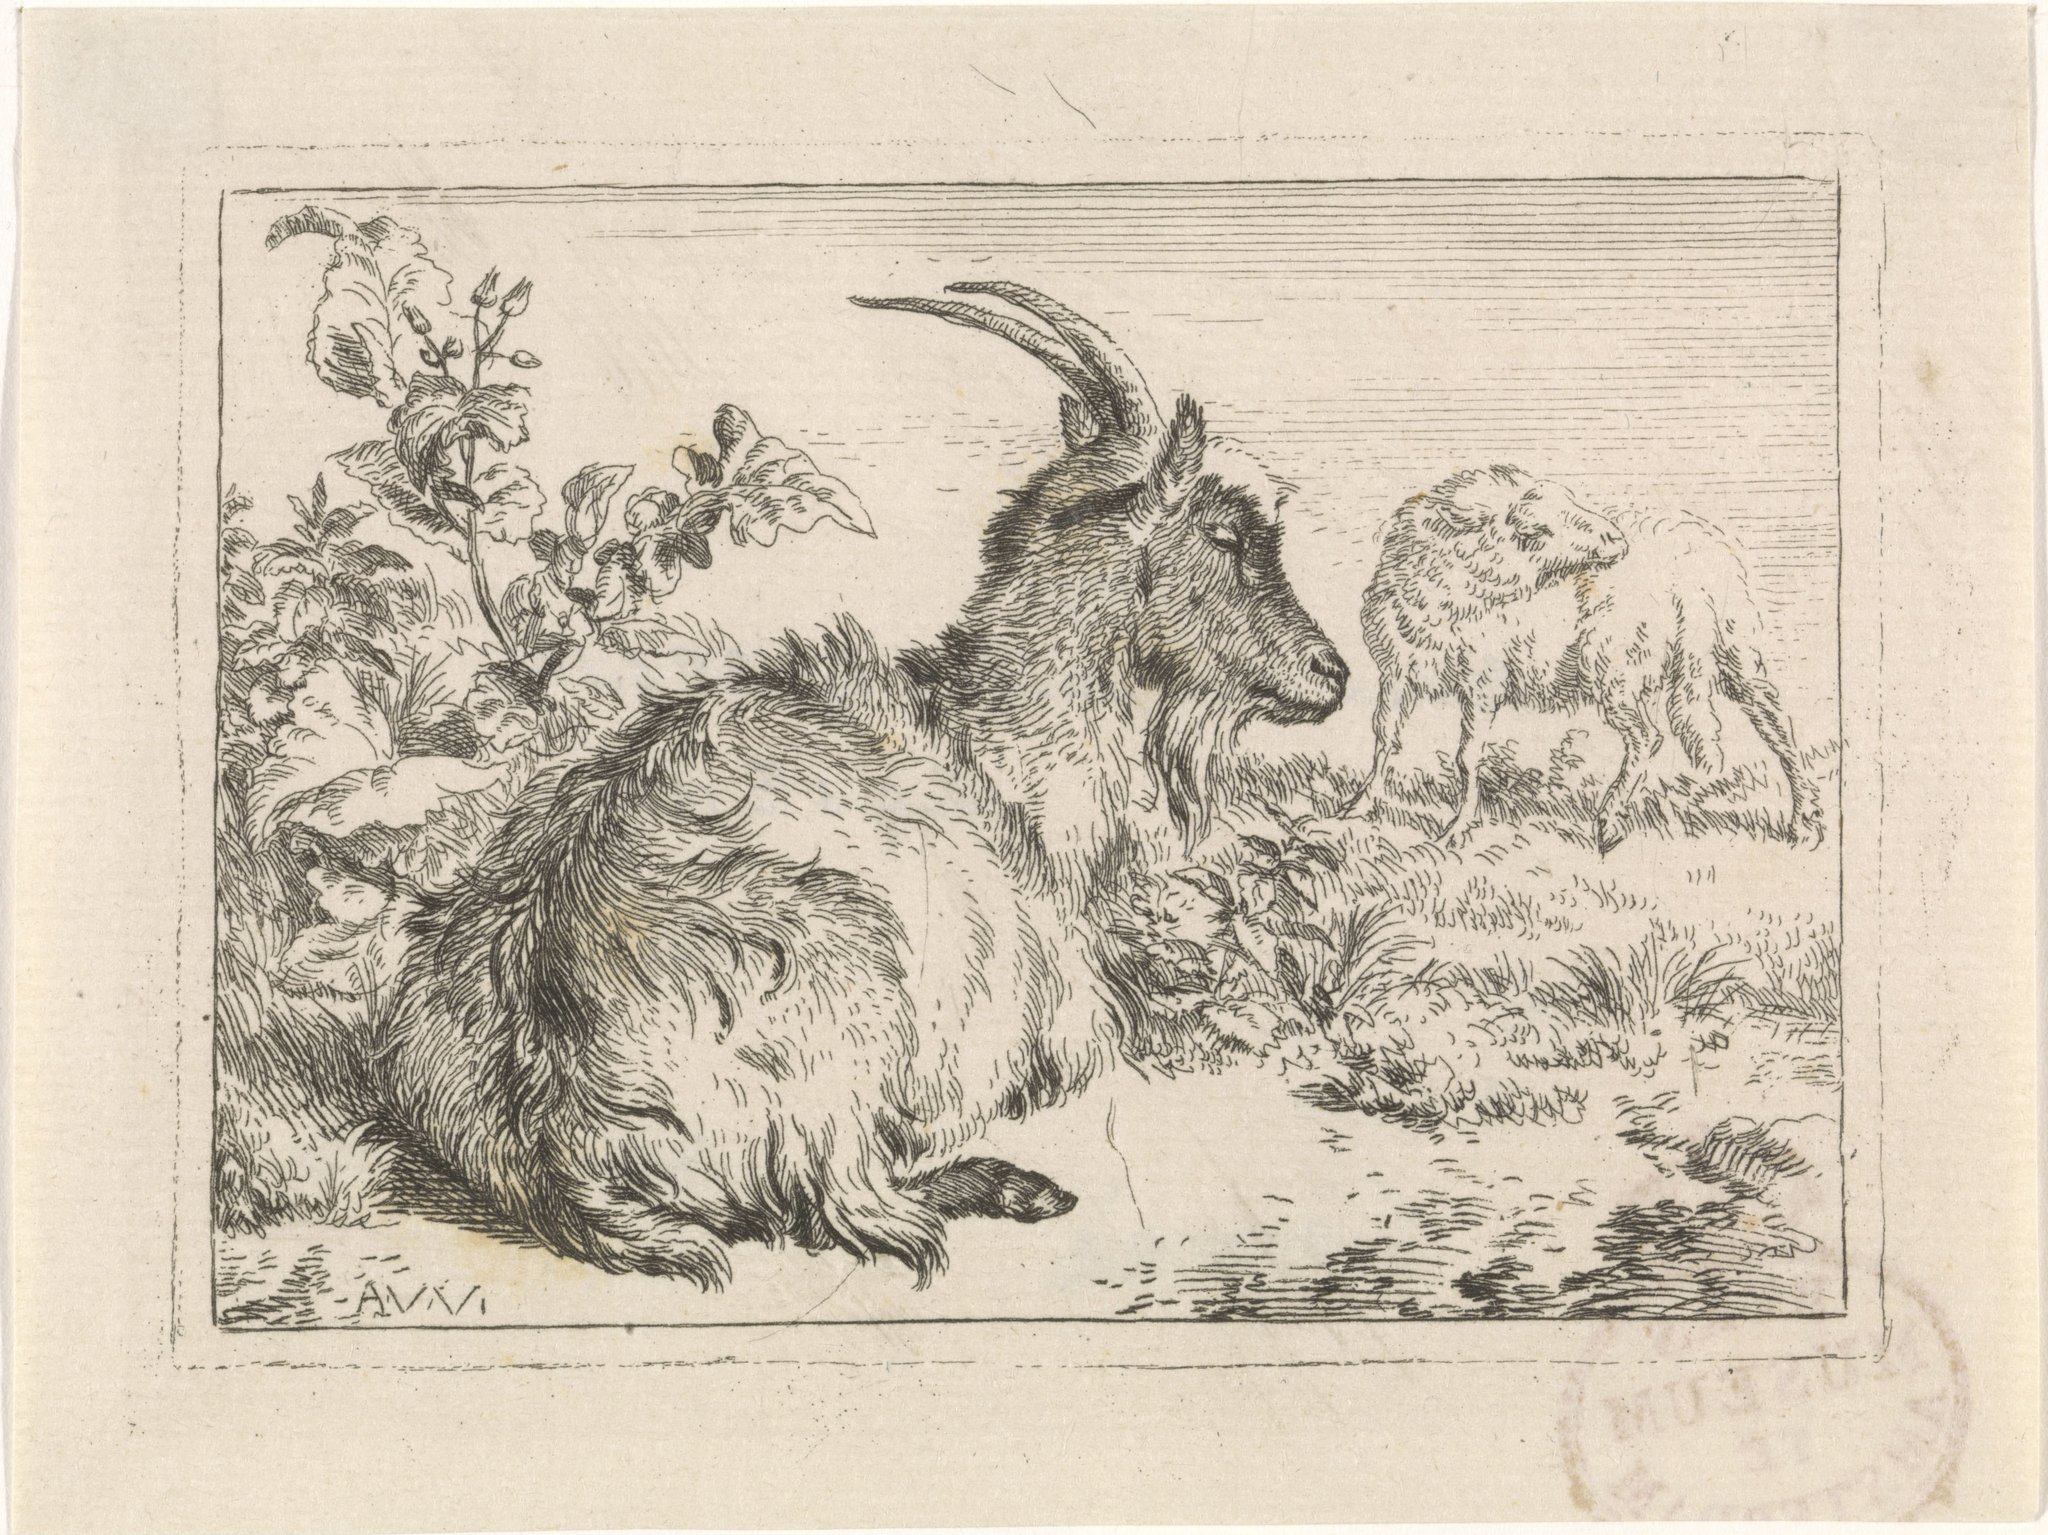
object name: print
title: Liggende geit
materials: paper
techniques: etching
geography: amsterdam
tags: goat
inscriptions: collector's mark: Lugt 12, inscription: ‘Copy/ etched at Amsterdam by B.P. Gibbon/ July 5th 1830/ JS’